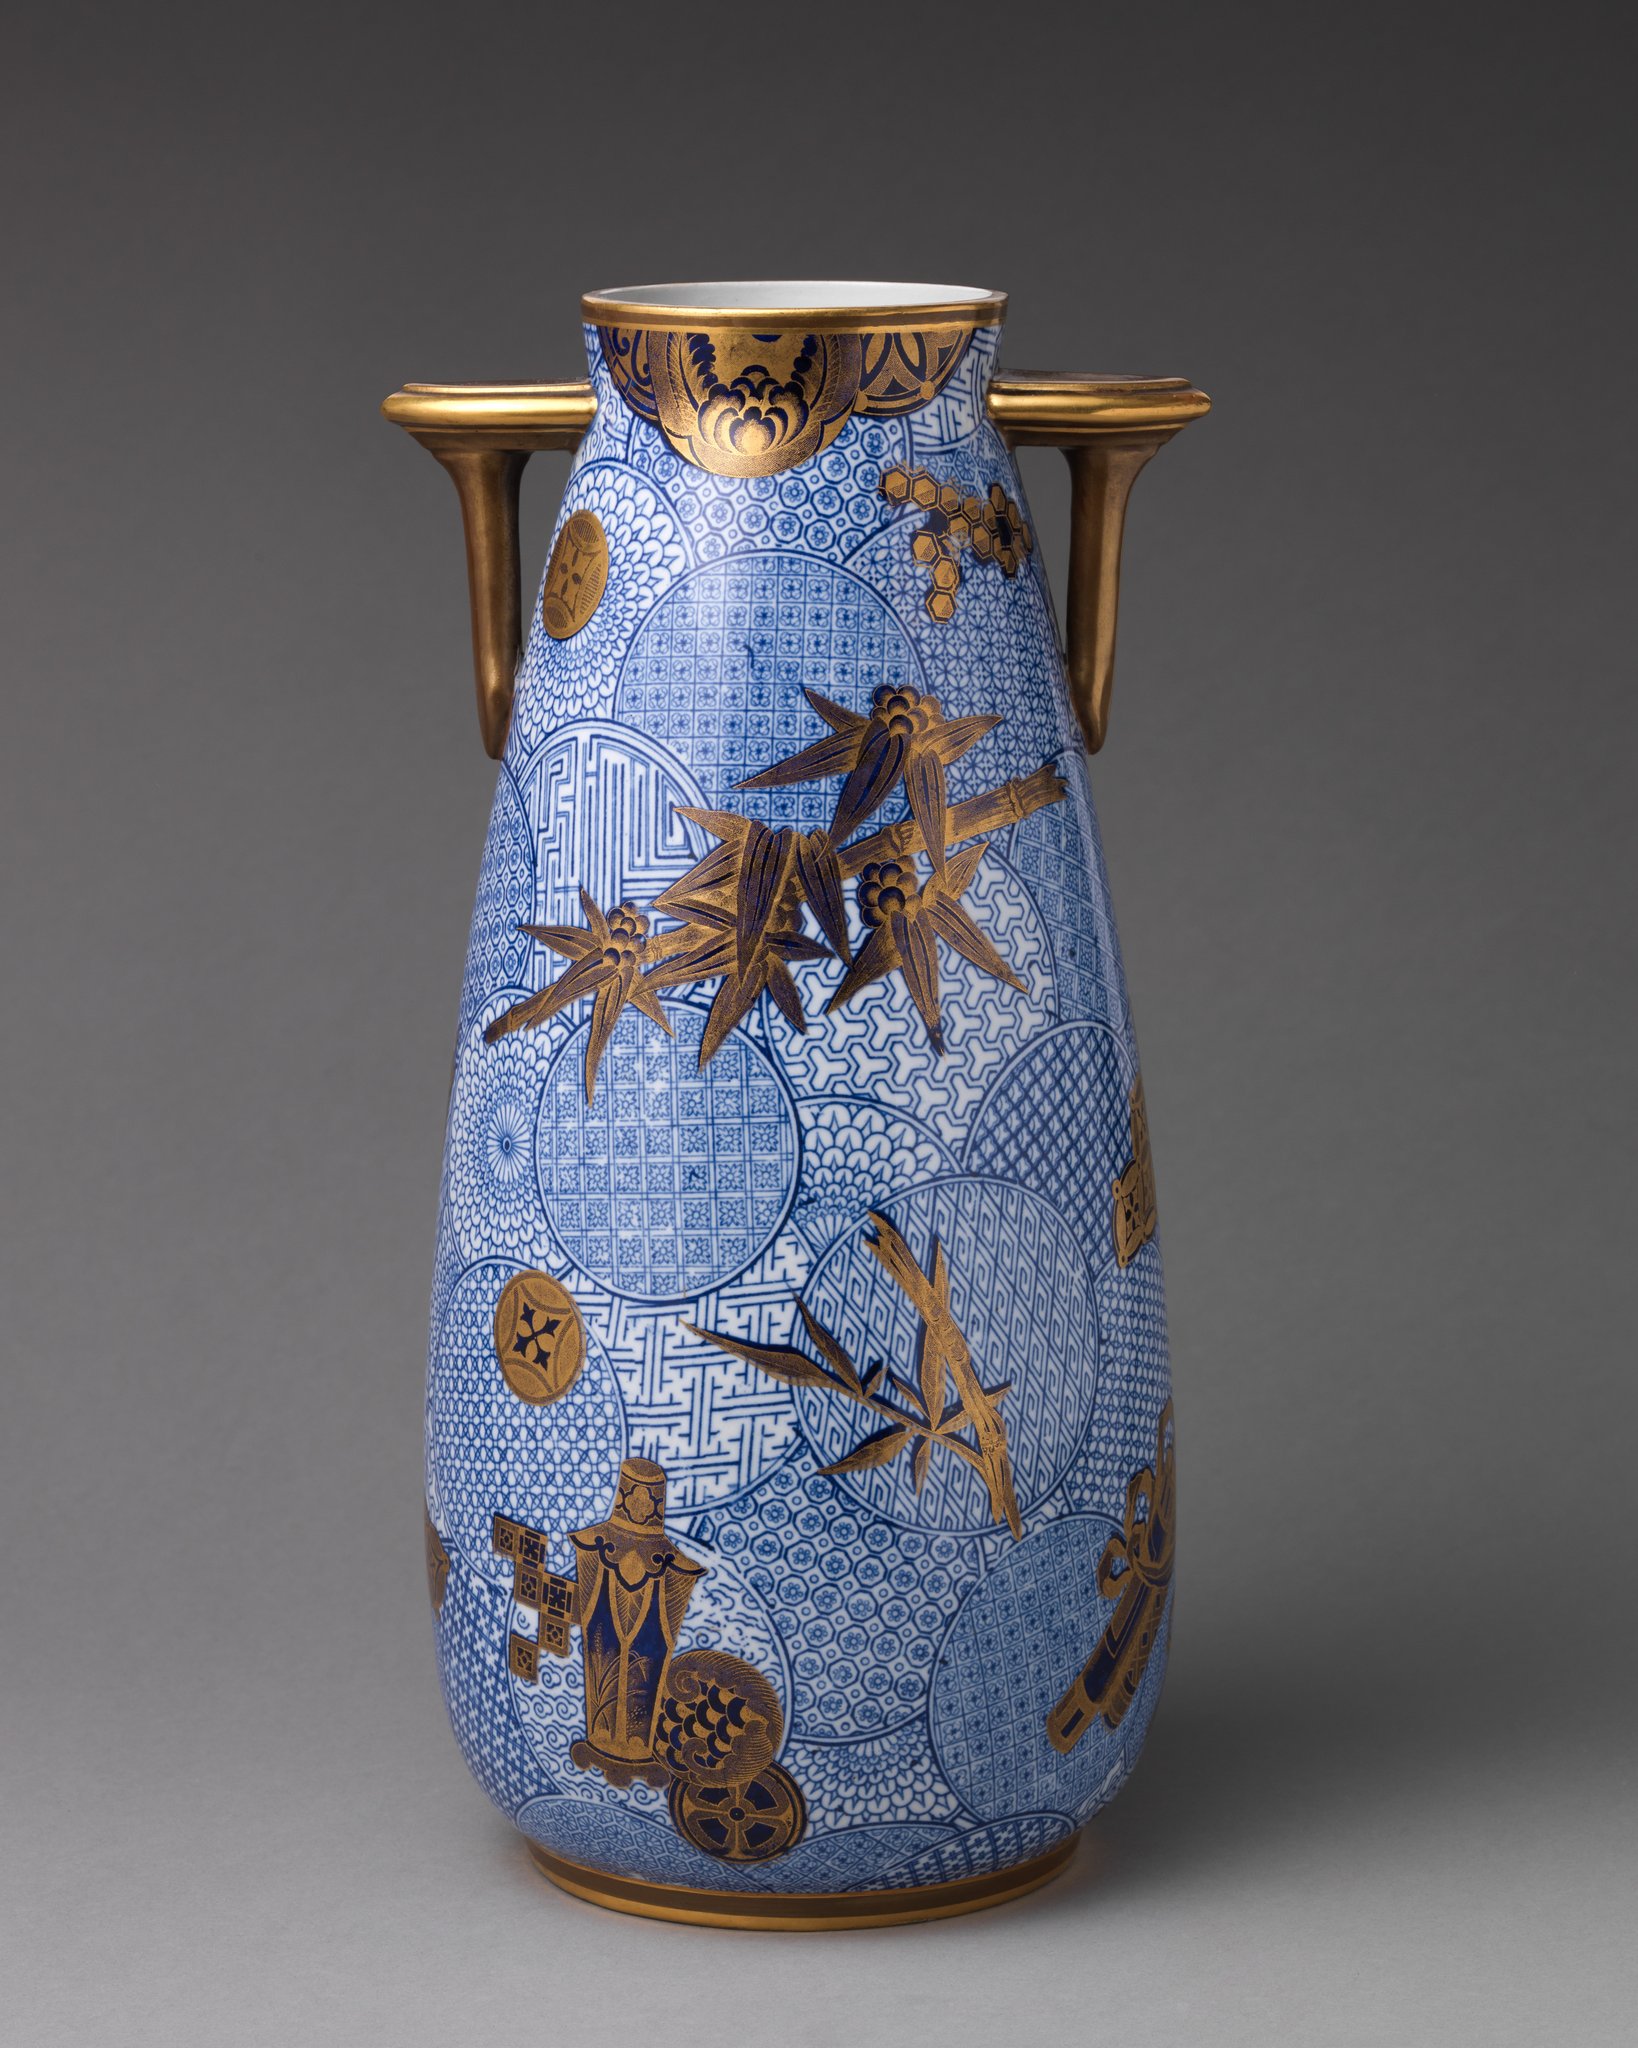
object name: vase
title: Vase (one of a pair)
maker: worcester factory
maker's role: maker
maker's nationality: british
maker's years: 1751-2008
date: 1879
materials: bone china